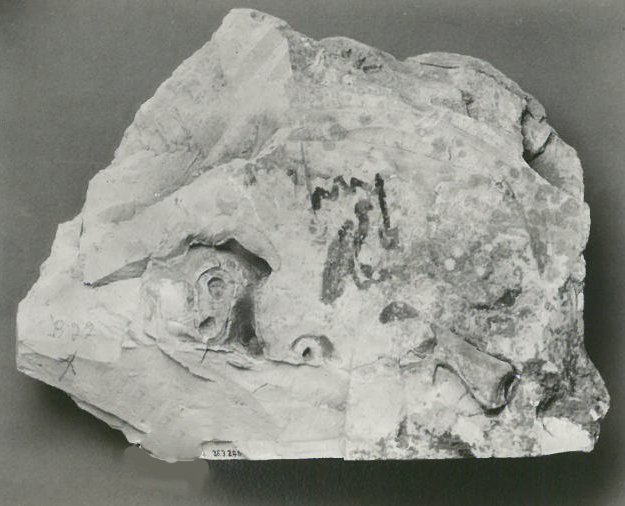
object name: name stone, tally, senenmut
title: Name Stone of Senenmut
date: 1479-1458 BCE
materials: limestone, paint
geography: egypt